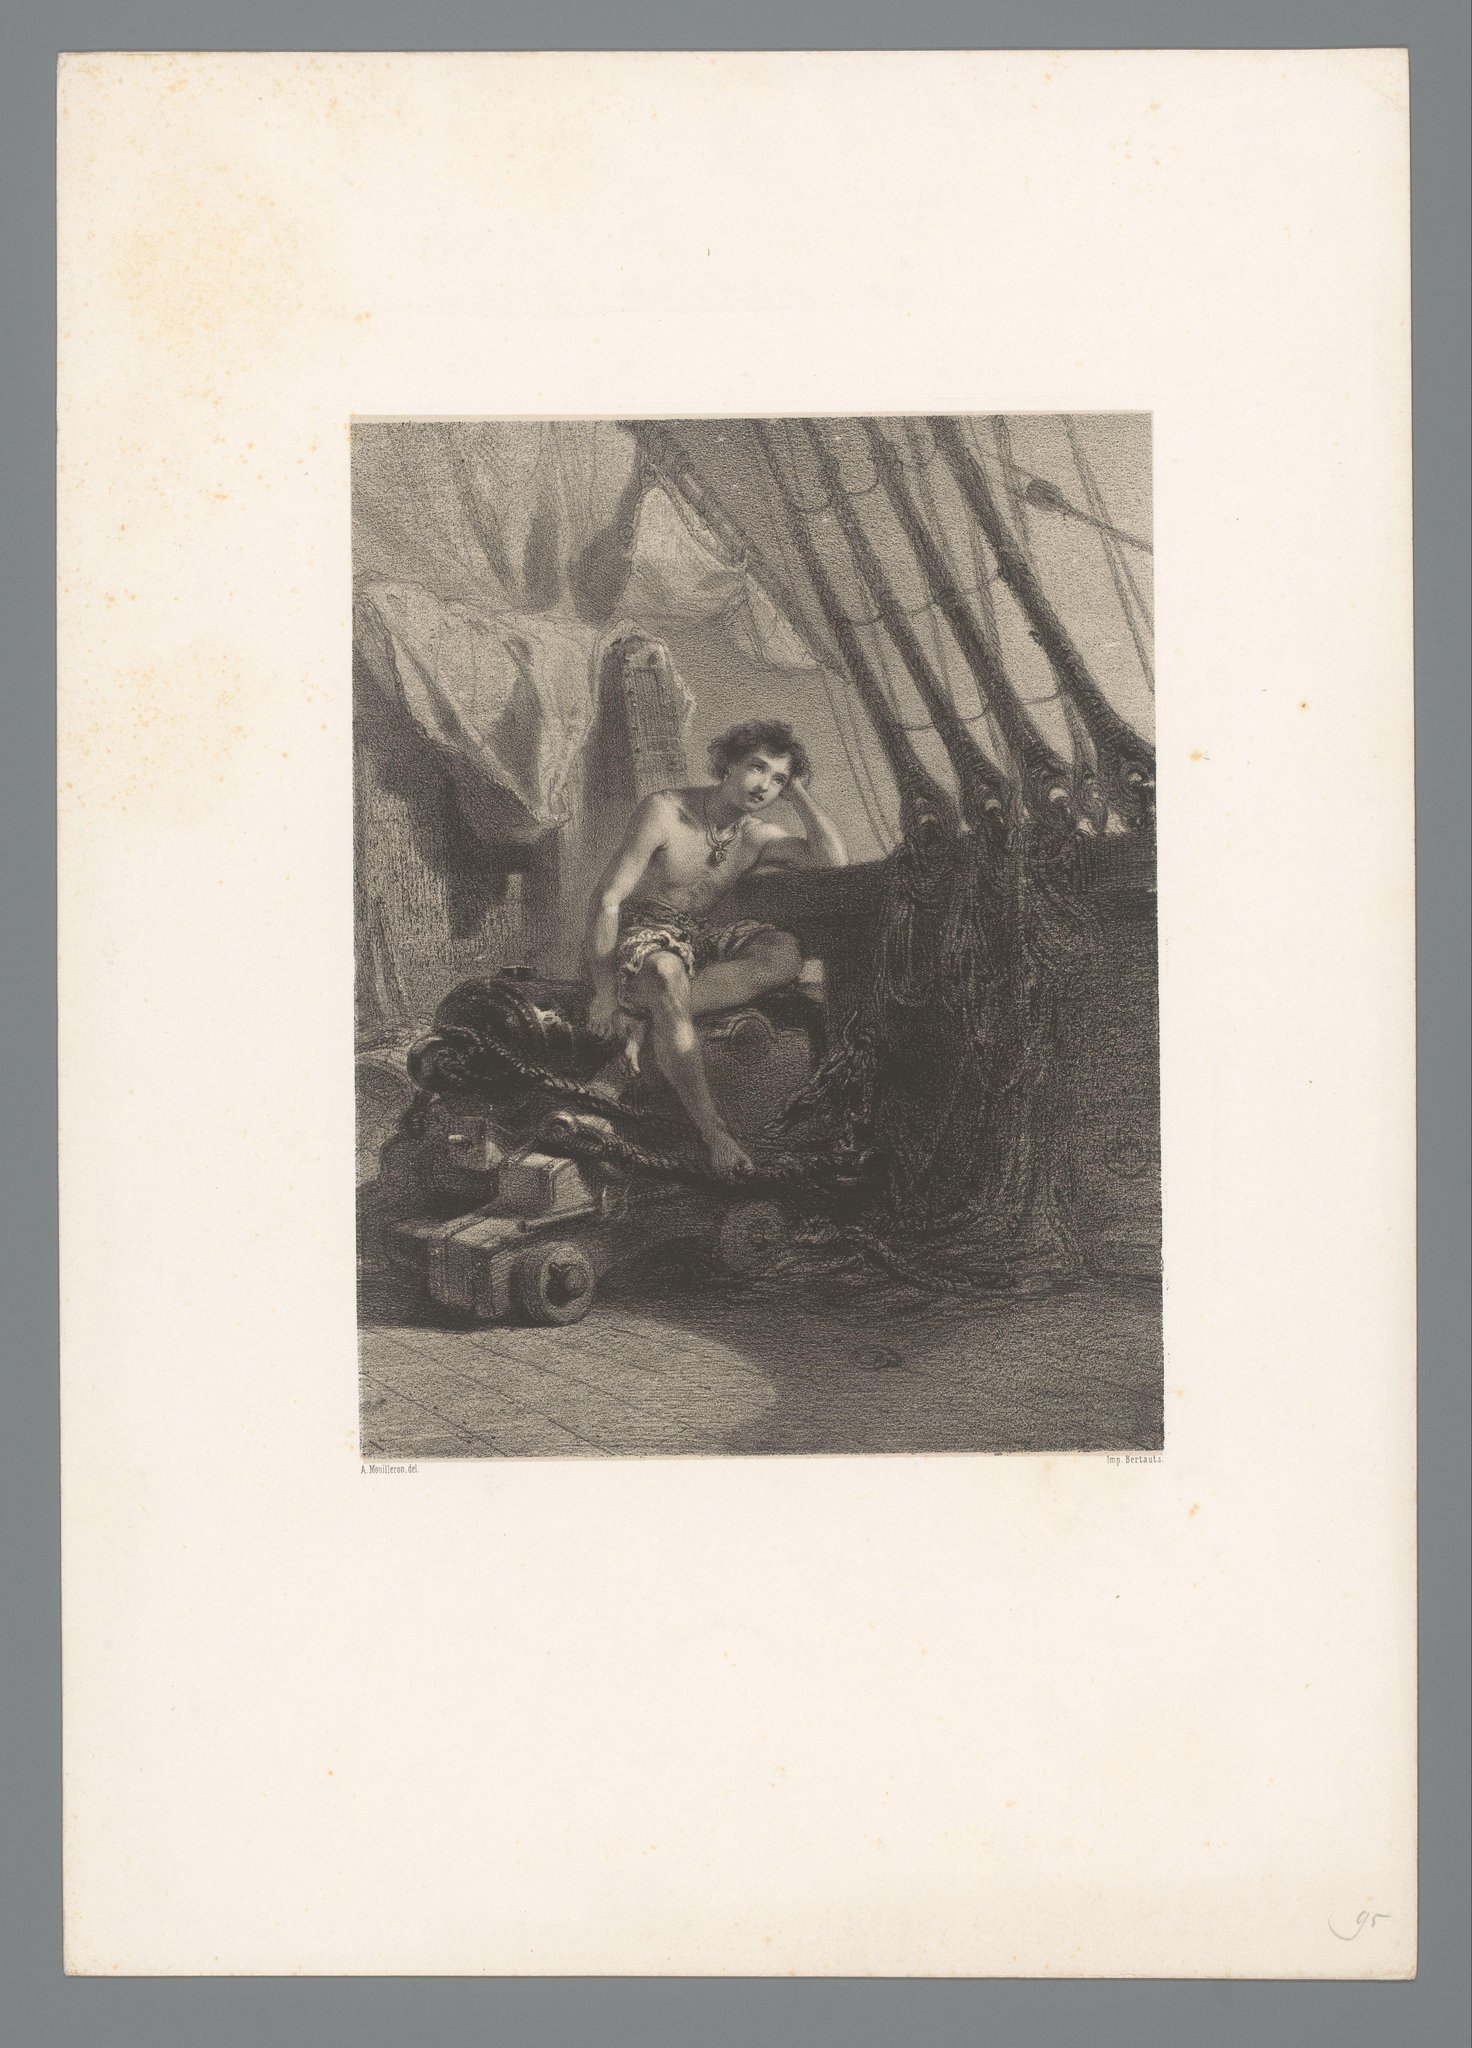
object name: print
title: Jongeman op kanon aan boord van een schip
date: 1830-1880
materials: paper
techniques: lithograph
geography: paris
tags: youth, adolescent, ships (in general), firearms: cannon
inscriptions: collector's mark: Lugt 2228